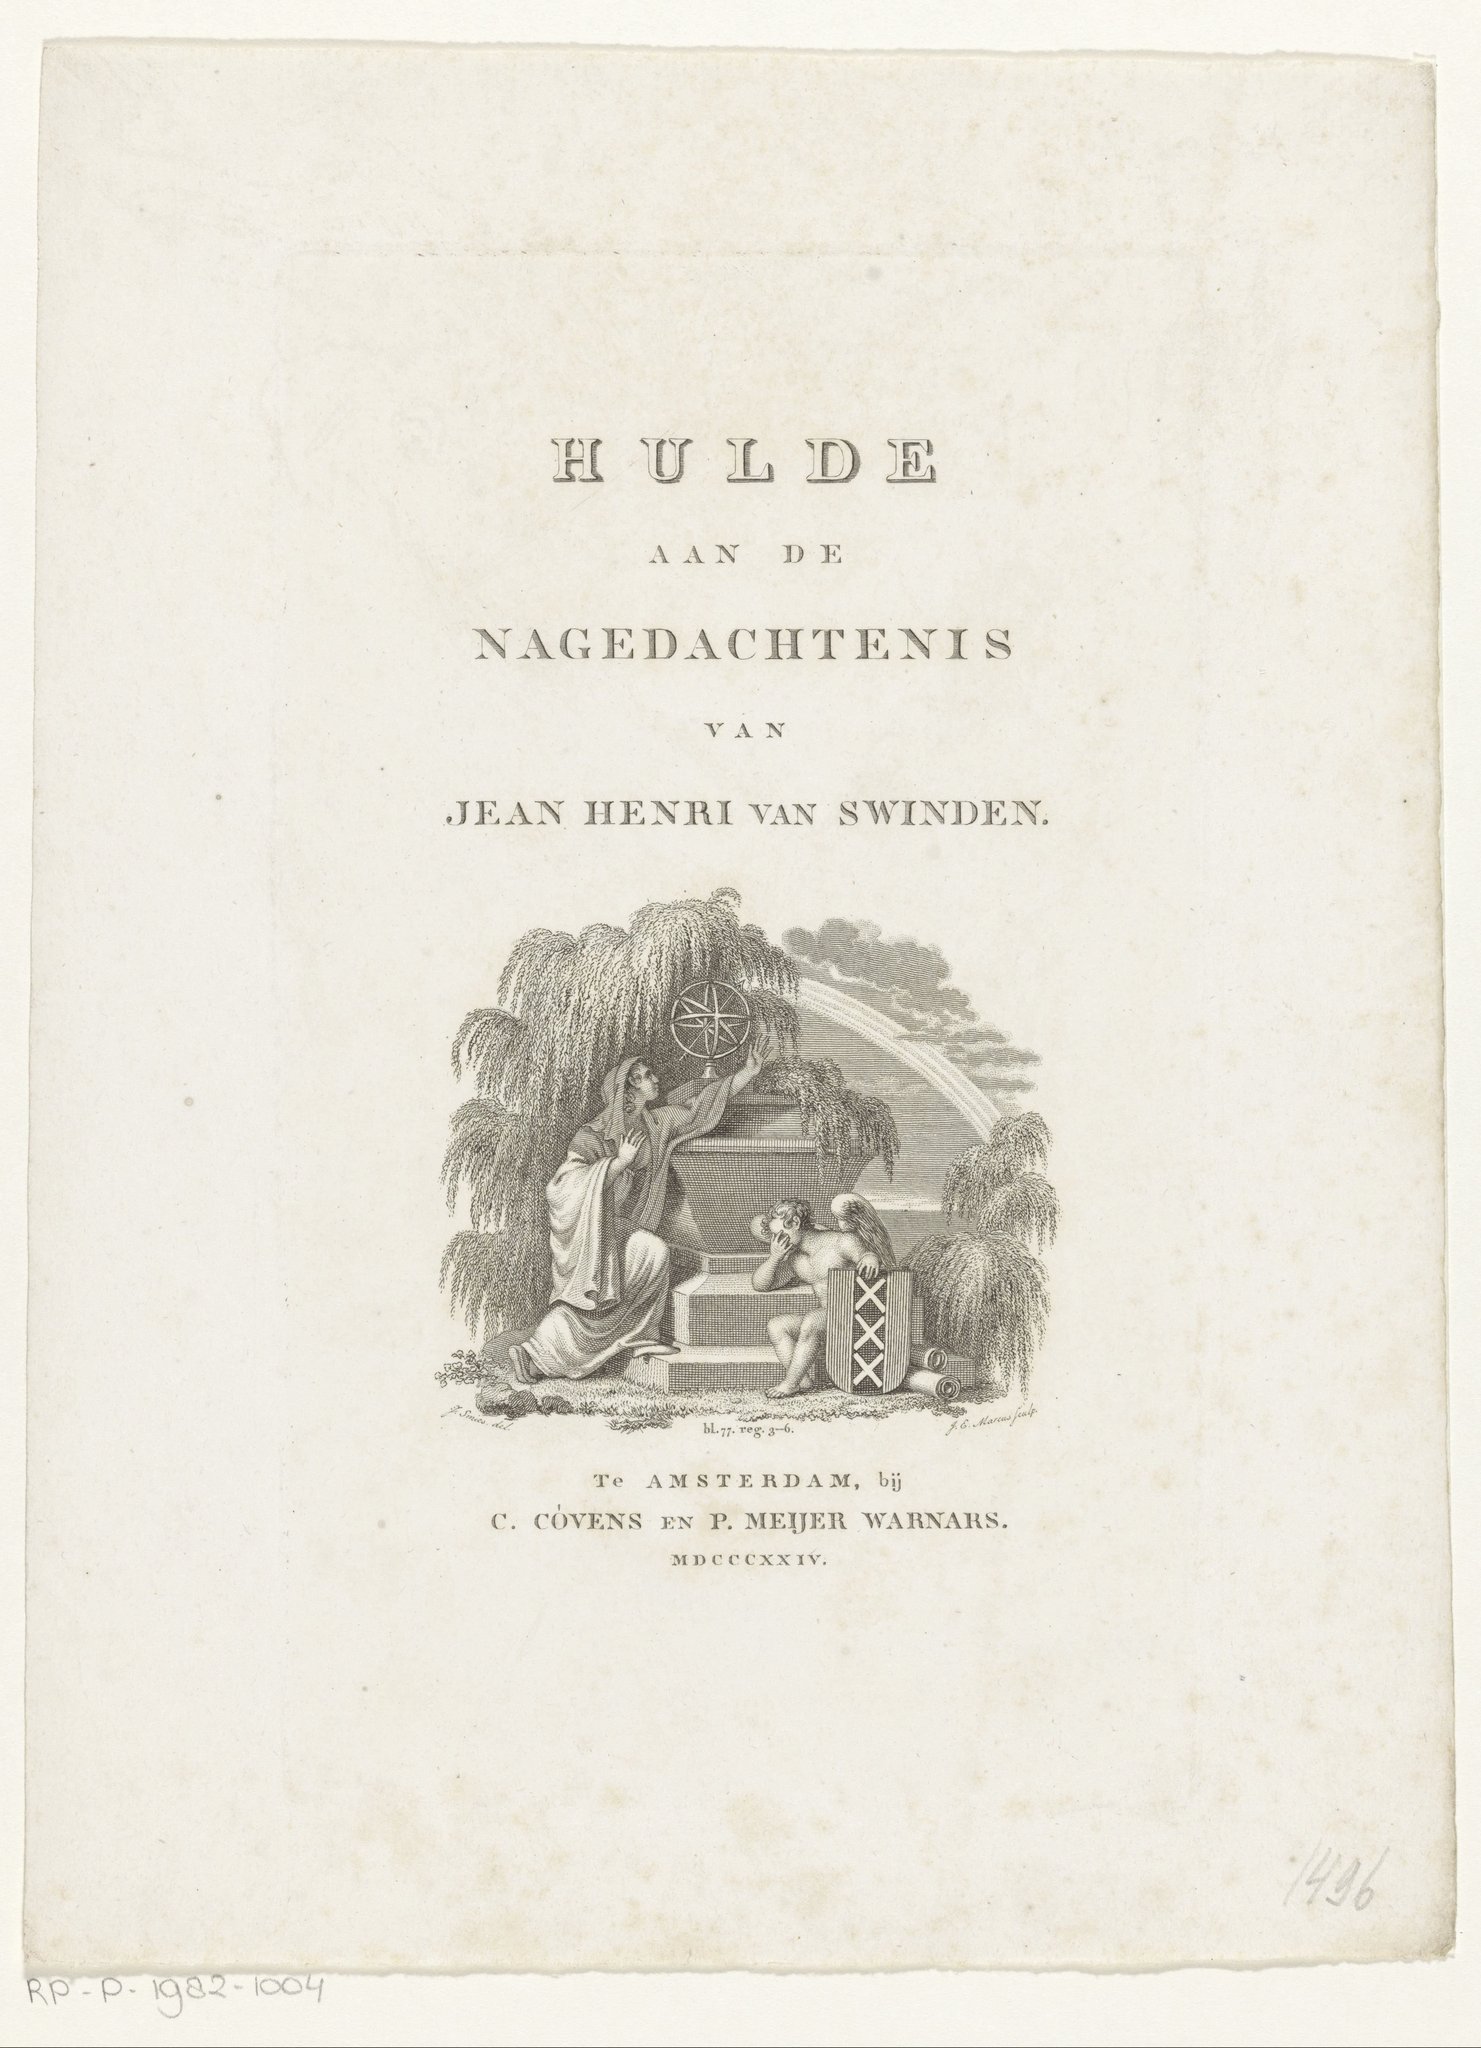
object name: print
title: Titelpagina voor: David Jacob van Lennep en Hendrik Harmen Klijn, Hulde aan de nagedachtenis van Jean Henri van Swinden, 1824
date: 1824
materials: paper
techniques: engraving, etching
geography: amsterdam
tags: the hague, amsterdam, physicist, jean henri van swinden, grave, tomb, mourning the dead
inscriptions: collector's mark: Lugt 2228, collector's mark: Lugt 2760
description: Titelpagina voor: Lennep, David Jacob van en Klijn, Hendrik Harmen. Hulde aan de nagedachtenis van Jean Henri van Swinden. Amsterdam: Covens, Cornelis en Meyerm Pieter, 1824.